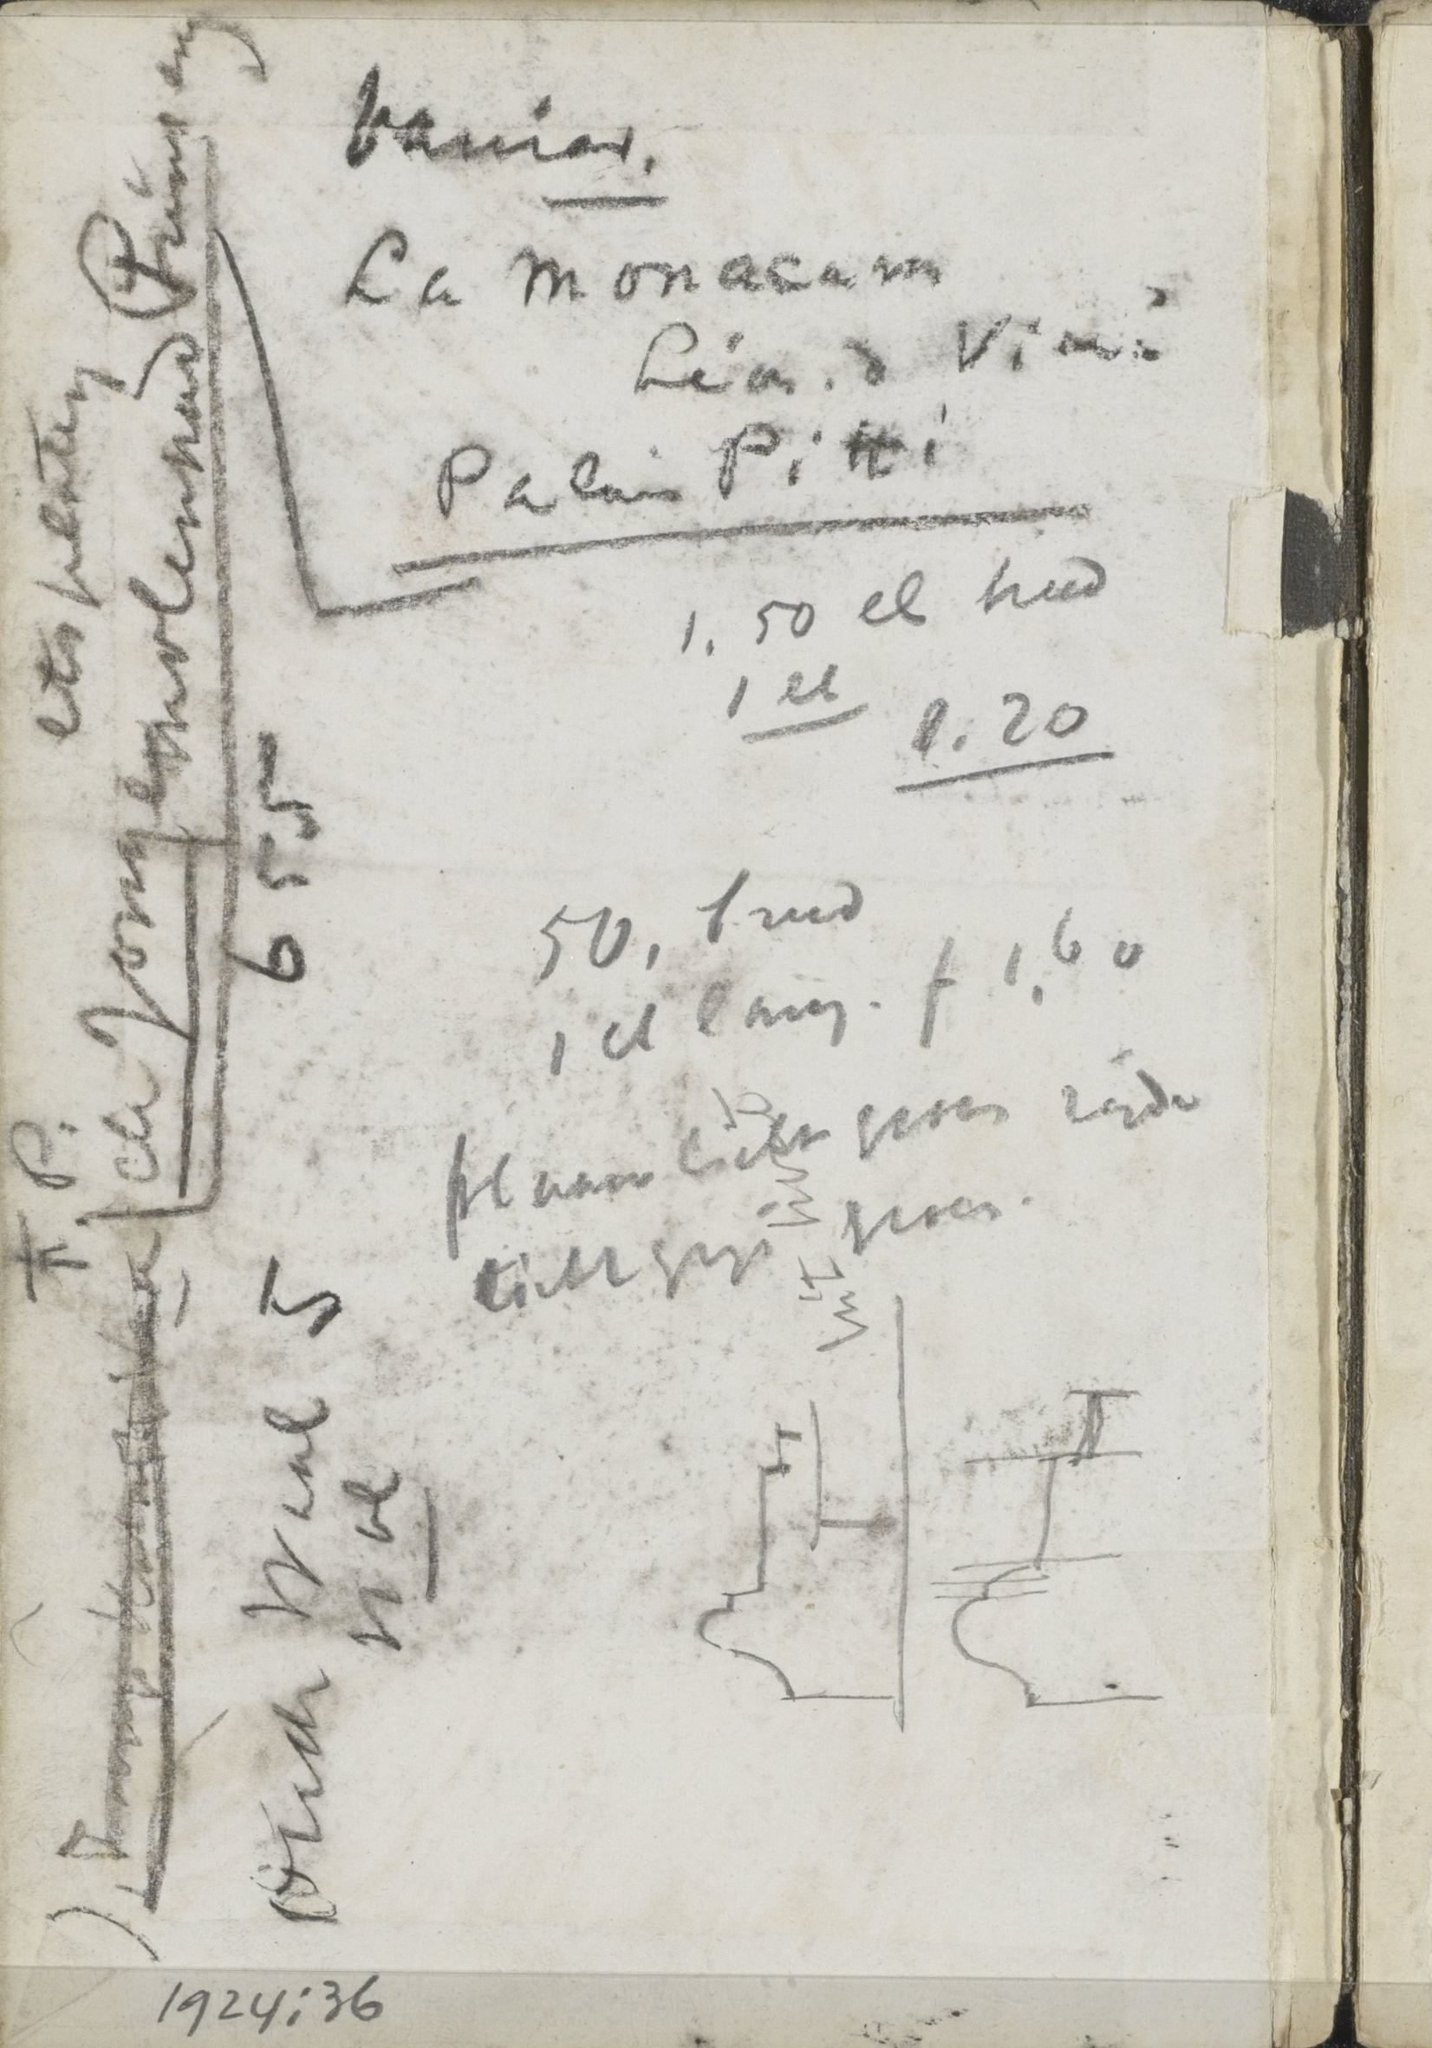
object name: endleaf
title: Architectuurstudies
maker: george hendrik breitner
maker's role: draughtsman, painter, print maker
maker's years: 1857-1923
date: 1886-1895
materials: chalk, paper, pencil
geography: amsterdam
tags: architectural detail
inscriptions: annotation: ‘Vanier.[?]/ La Monaca[...]/ Lia d Via[...]/ Palais Pitti [...]/ [...] ets / de Jong[...] Prinseng/ Oude Waal 5 [...]’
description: Pagina 1, voorste schutblad, uit een schetsboek met 20 bladen.